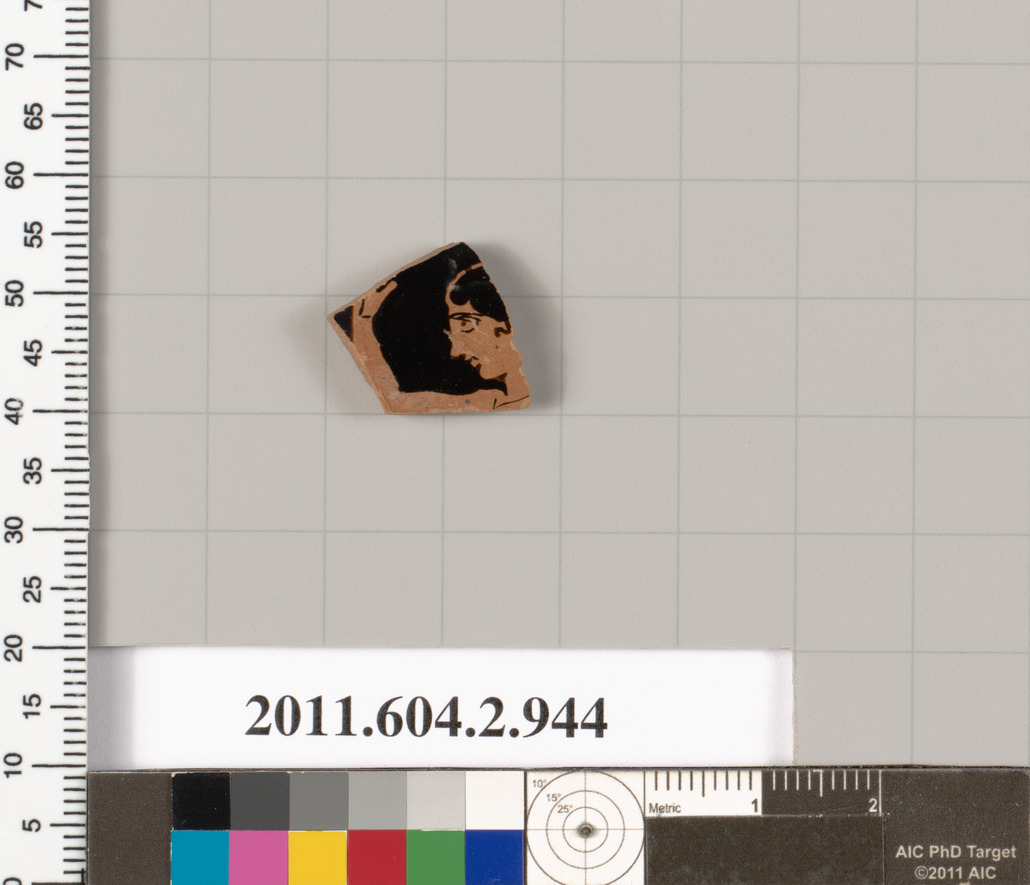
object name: oinochoe fragment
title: Terracotta fragment of an oinochoe (jug)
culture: greek, attic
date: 467-435 BCE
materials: terracotta